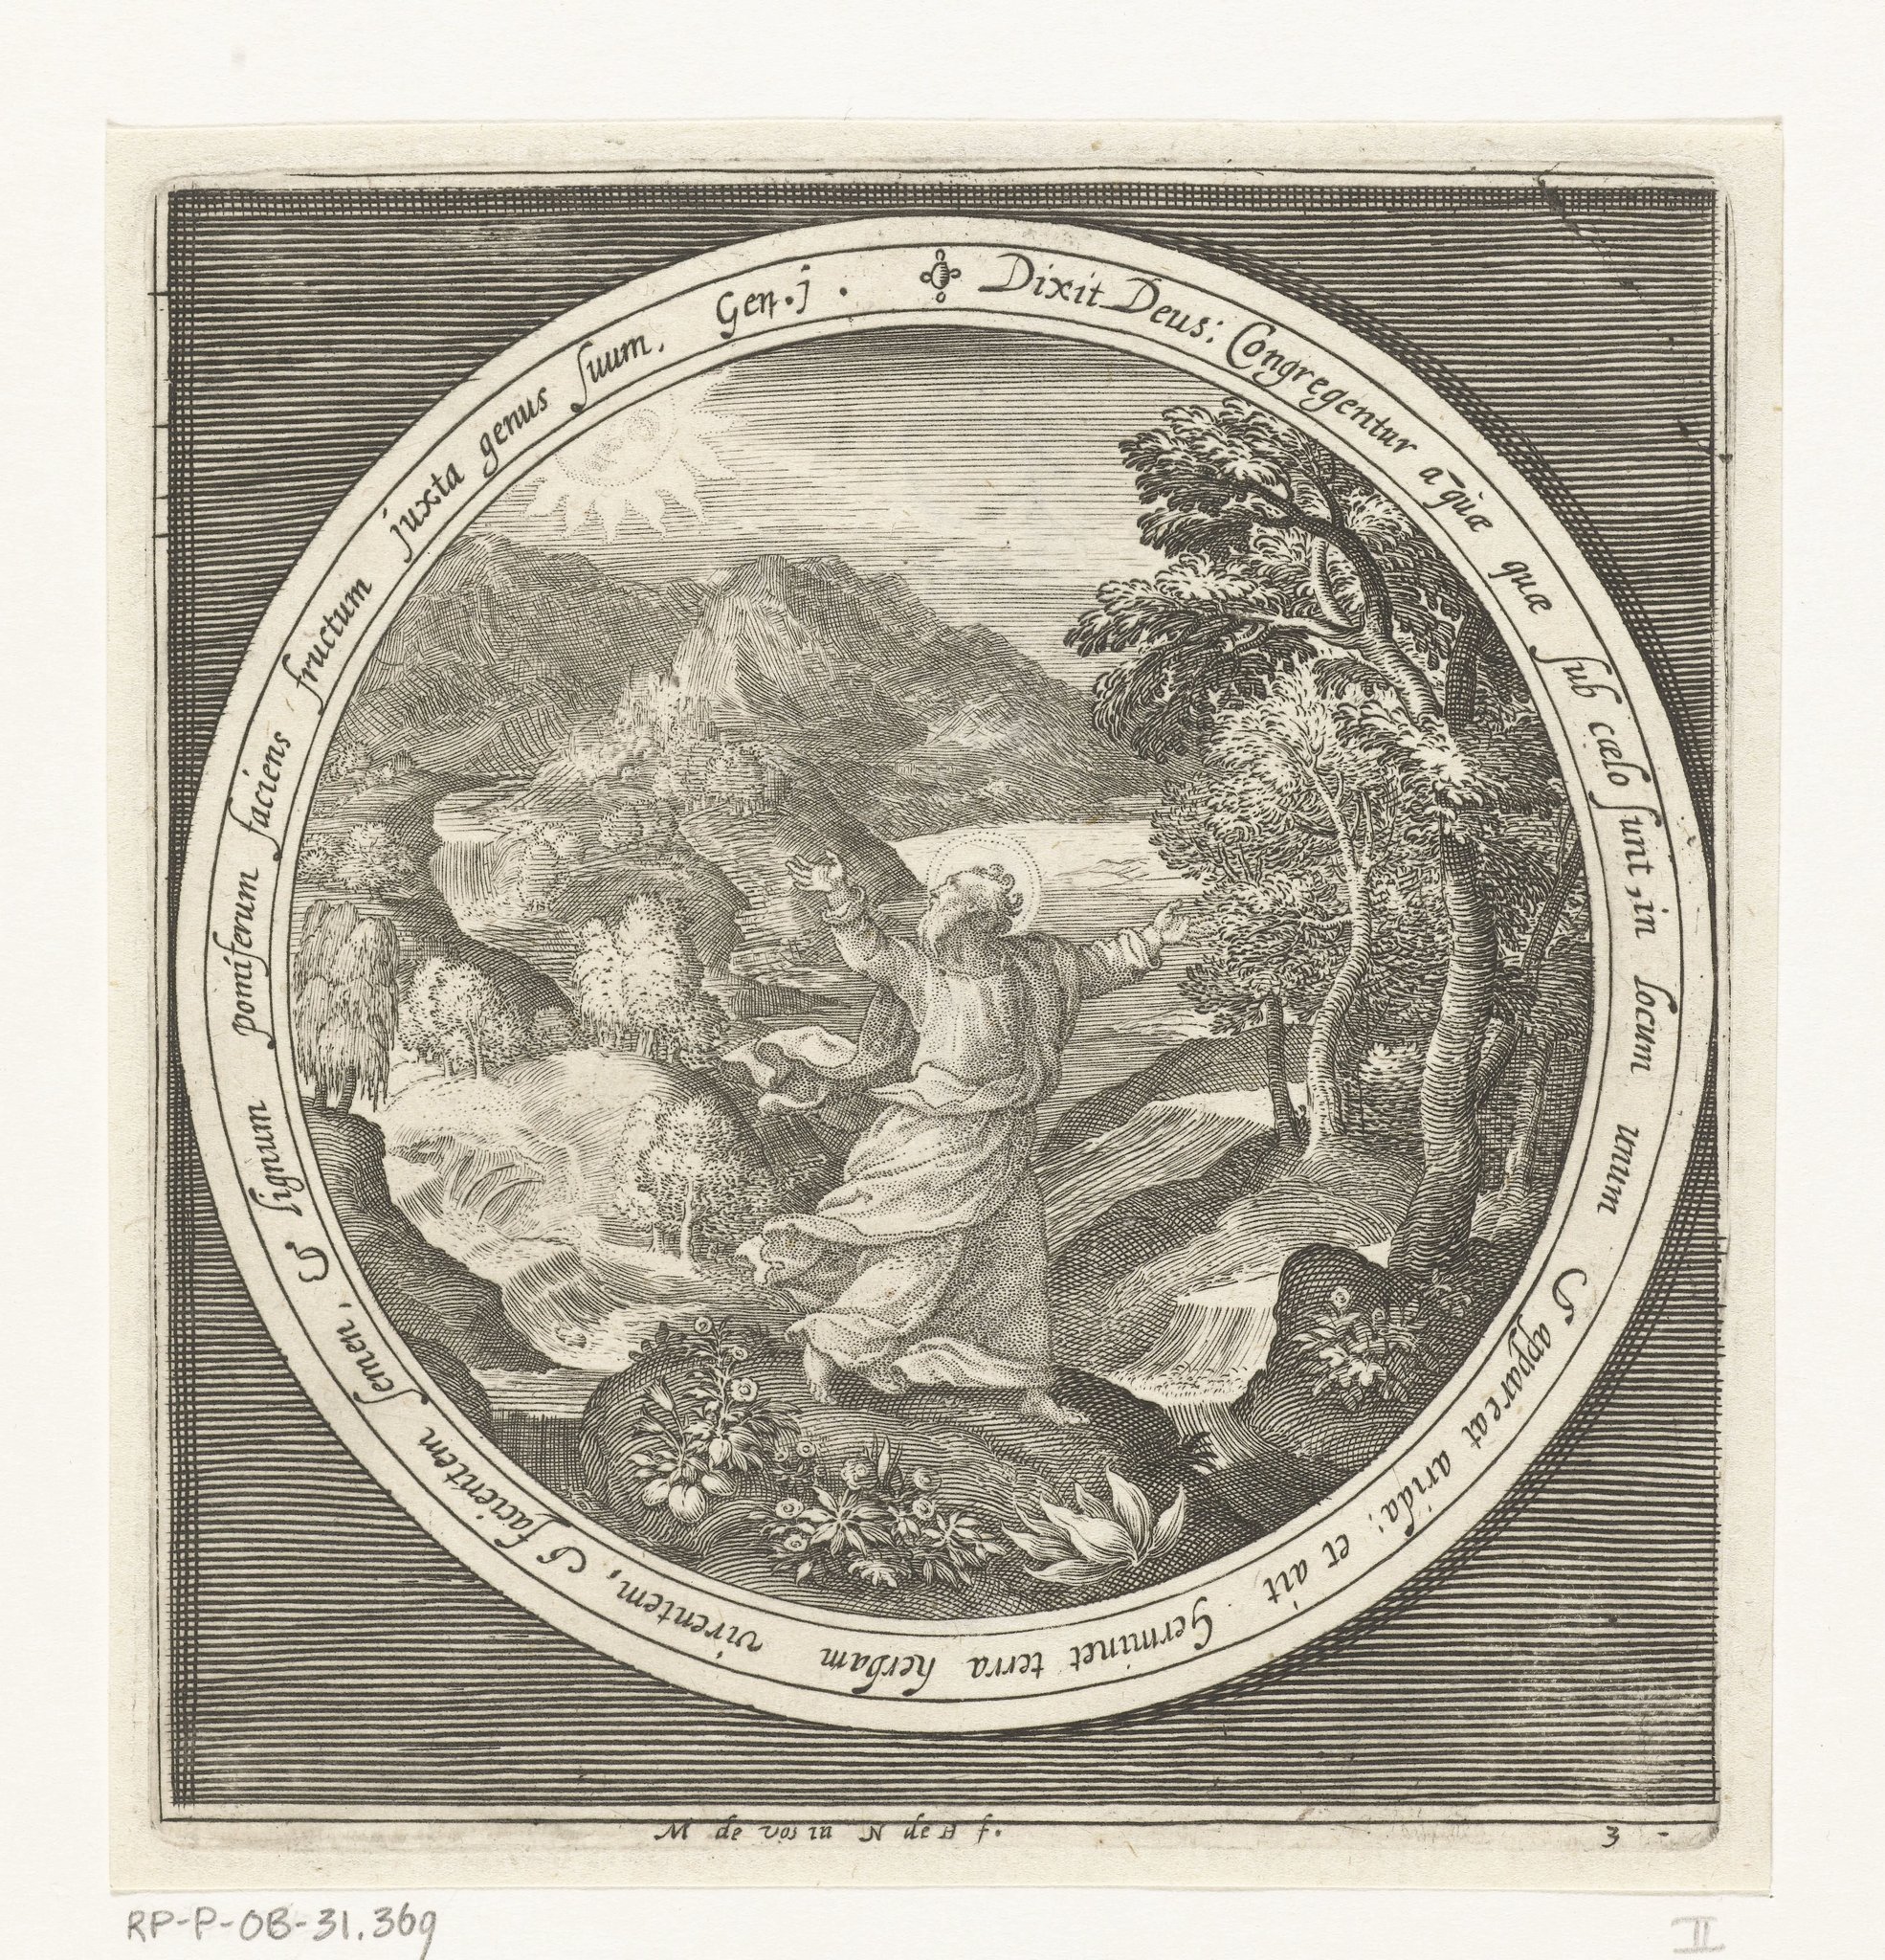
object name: print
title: Van schepping tot verdrijving uit paradijs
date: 1581-1656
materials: paper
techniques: engraving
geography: netherlands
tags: gathering of the waters below the firmament; dry land appears and produces all kinds of plants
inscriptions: collector's mark: Lugt 2228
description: Derde dag van schepping: God schept land en zaadvormende planten en bomen met vruchten die zaden dragen. Het water trekt zich terug in rivieren en de zee. In medaillon met als opschrift een bijbeltekst in Latijn uit Genesis 1, binnen rechthoekige omlijsting.